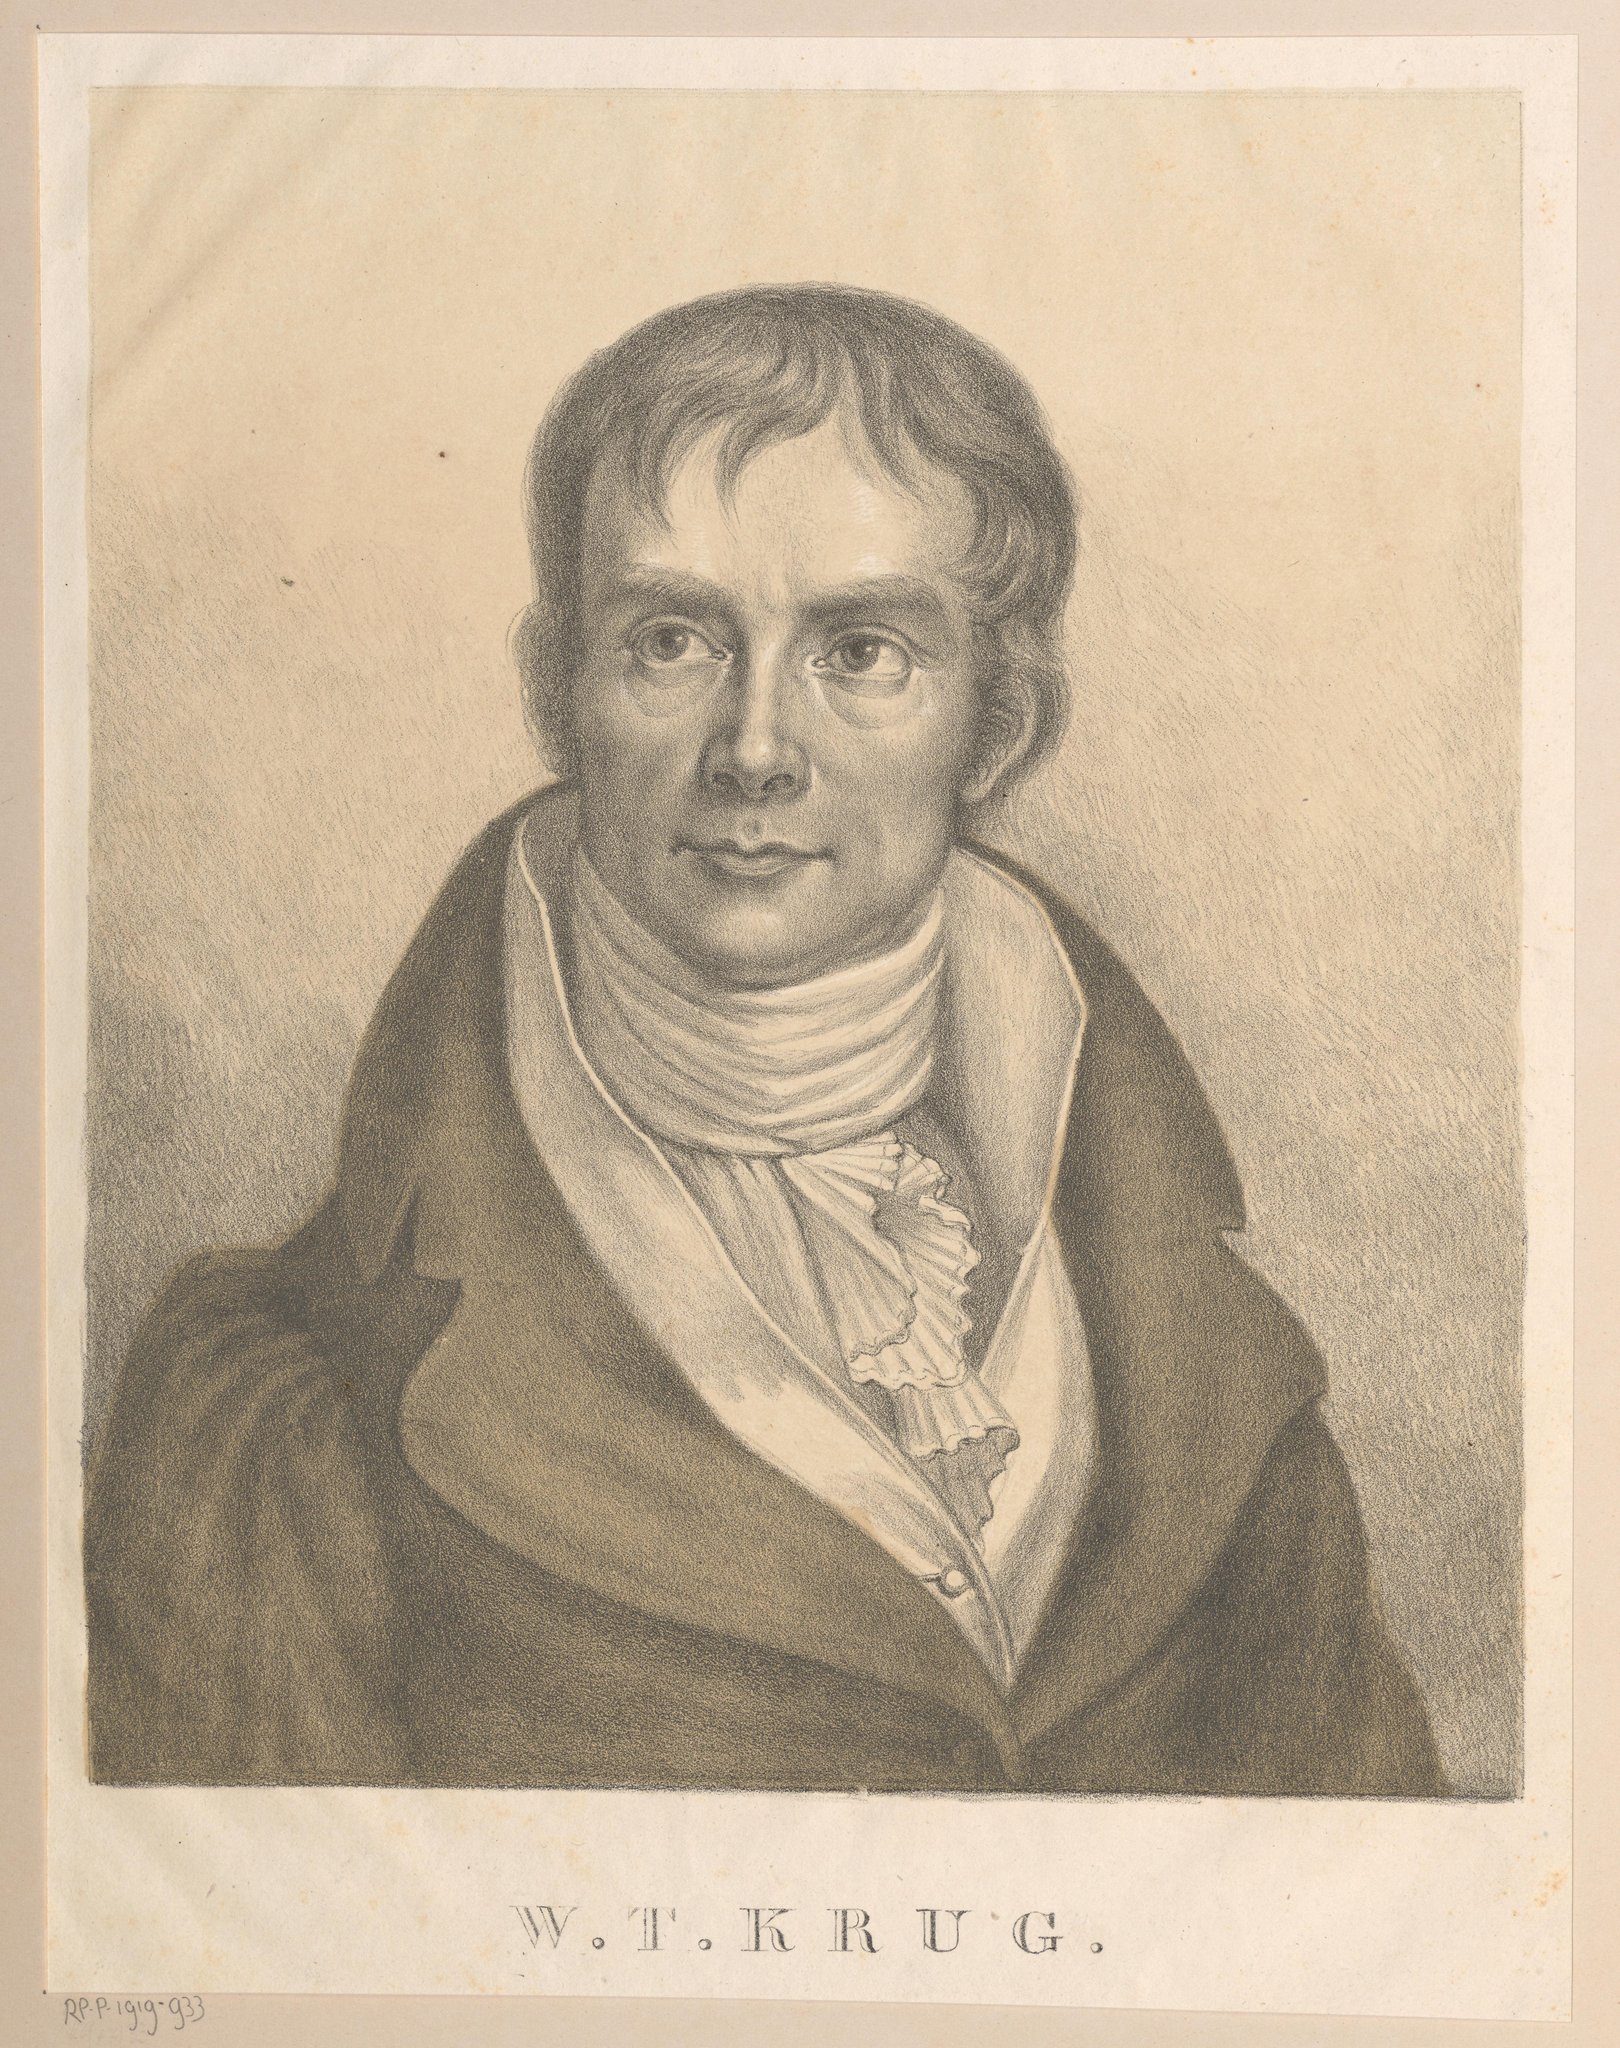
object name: print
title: Portret van Wilhelm Traugott Krug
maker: Anonymous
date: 1790-1899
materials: paper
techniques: tone lithography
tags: historical persons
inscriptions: collector's mark: Lugt 2228